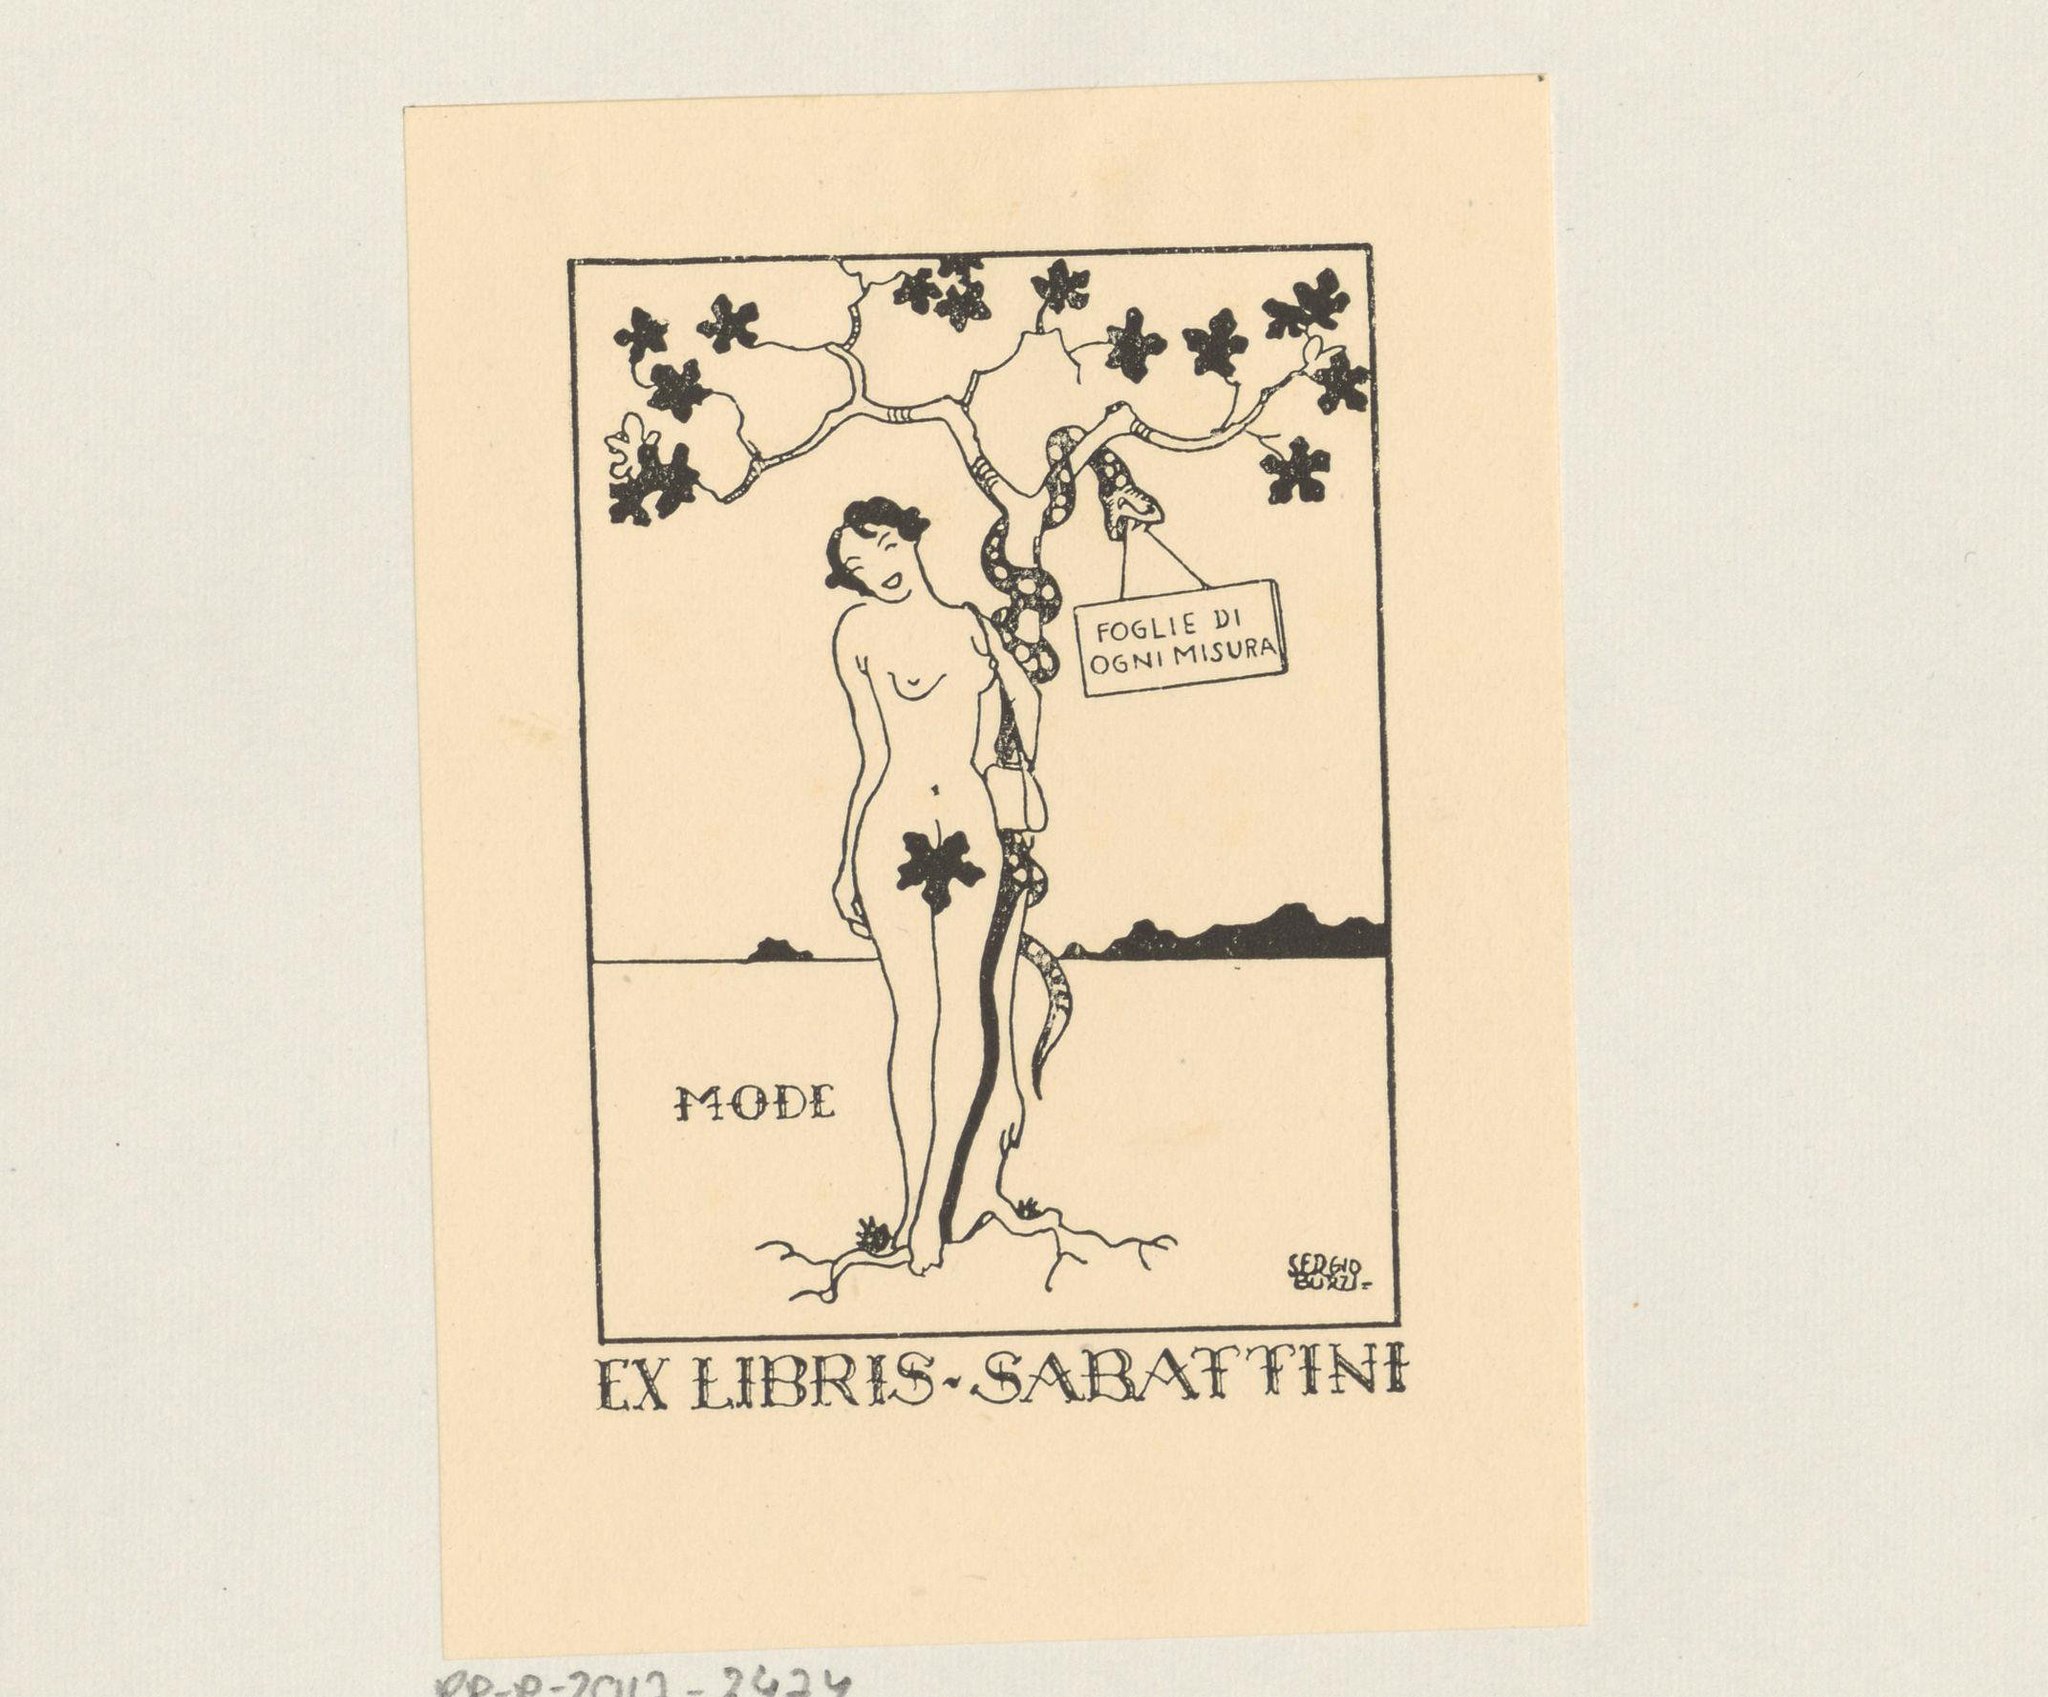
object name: bookplate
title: Foglie di ogni misura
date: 1945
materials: paper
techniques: printing block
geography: bologna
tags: gino sabattini, woman (showing herself) undressed, quasi-nude, the tree of knowledge of good and evil (whose fruit, usually apples or figs, brings death); the tree may be guarded by the serpent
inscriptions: inscription: ‘S. Burzi - Bologna - 1945’